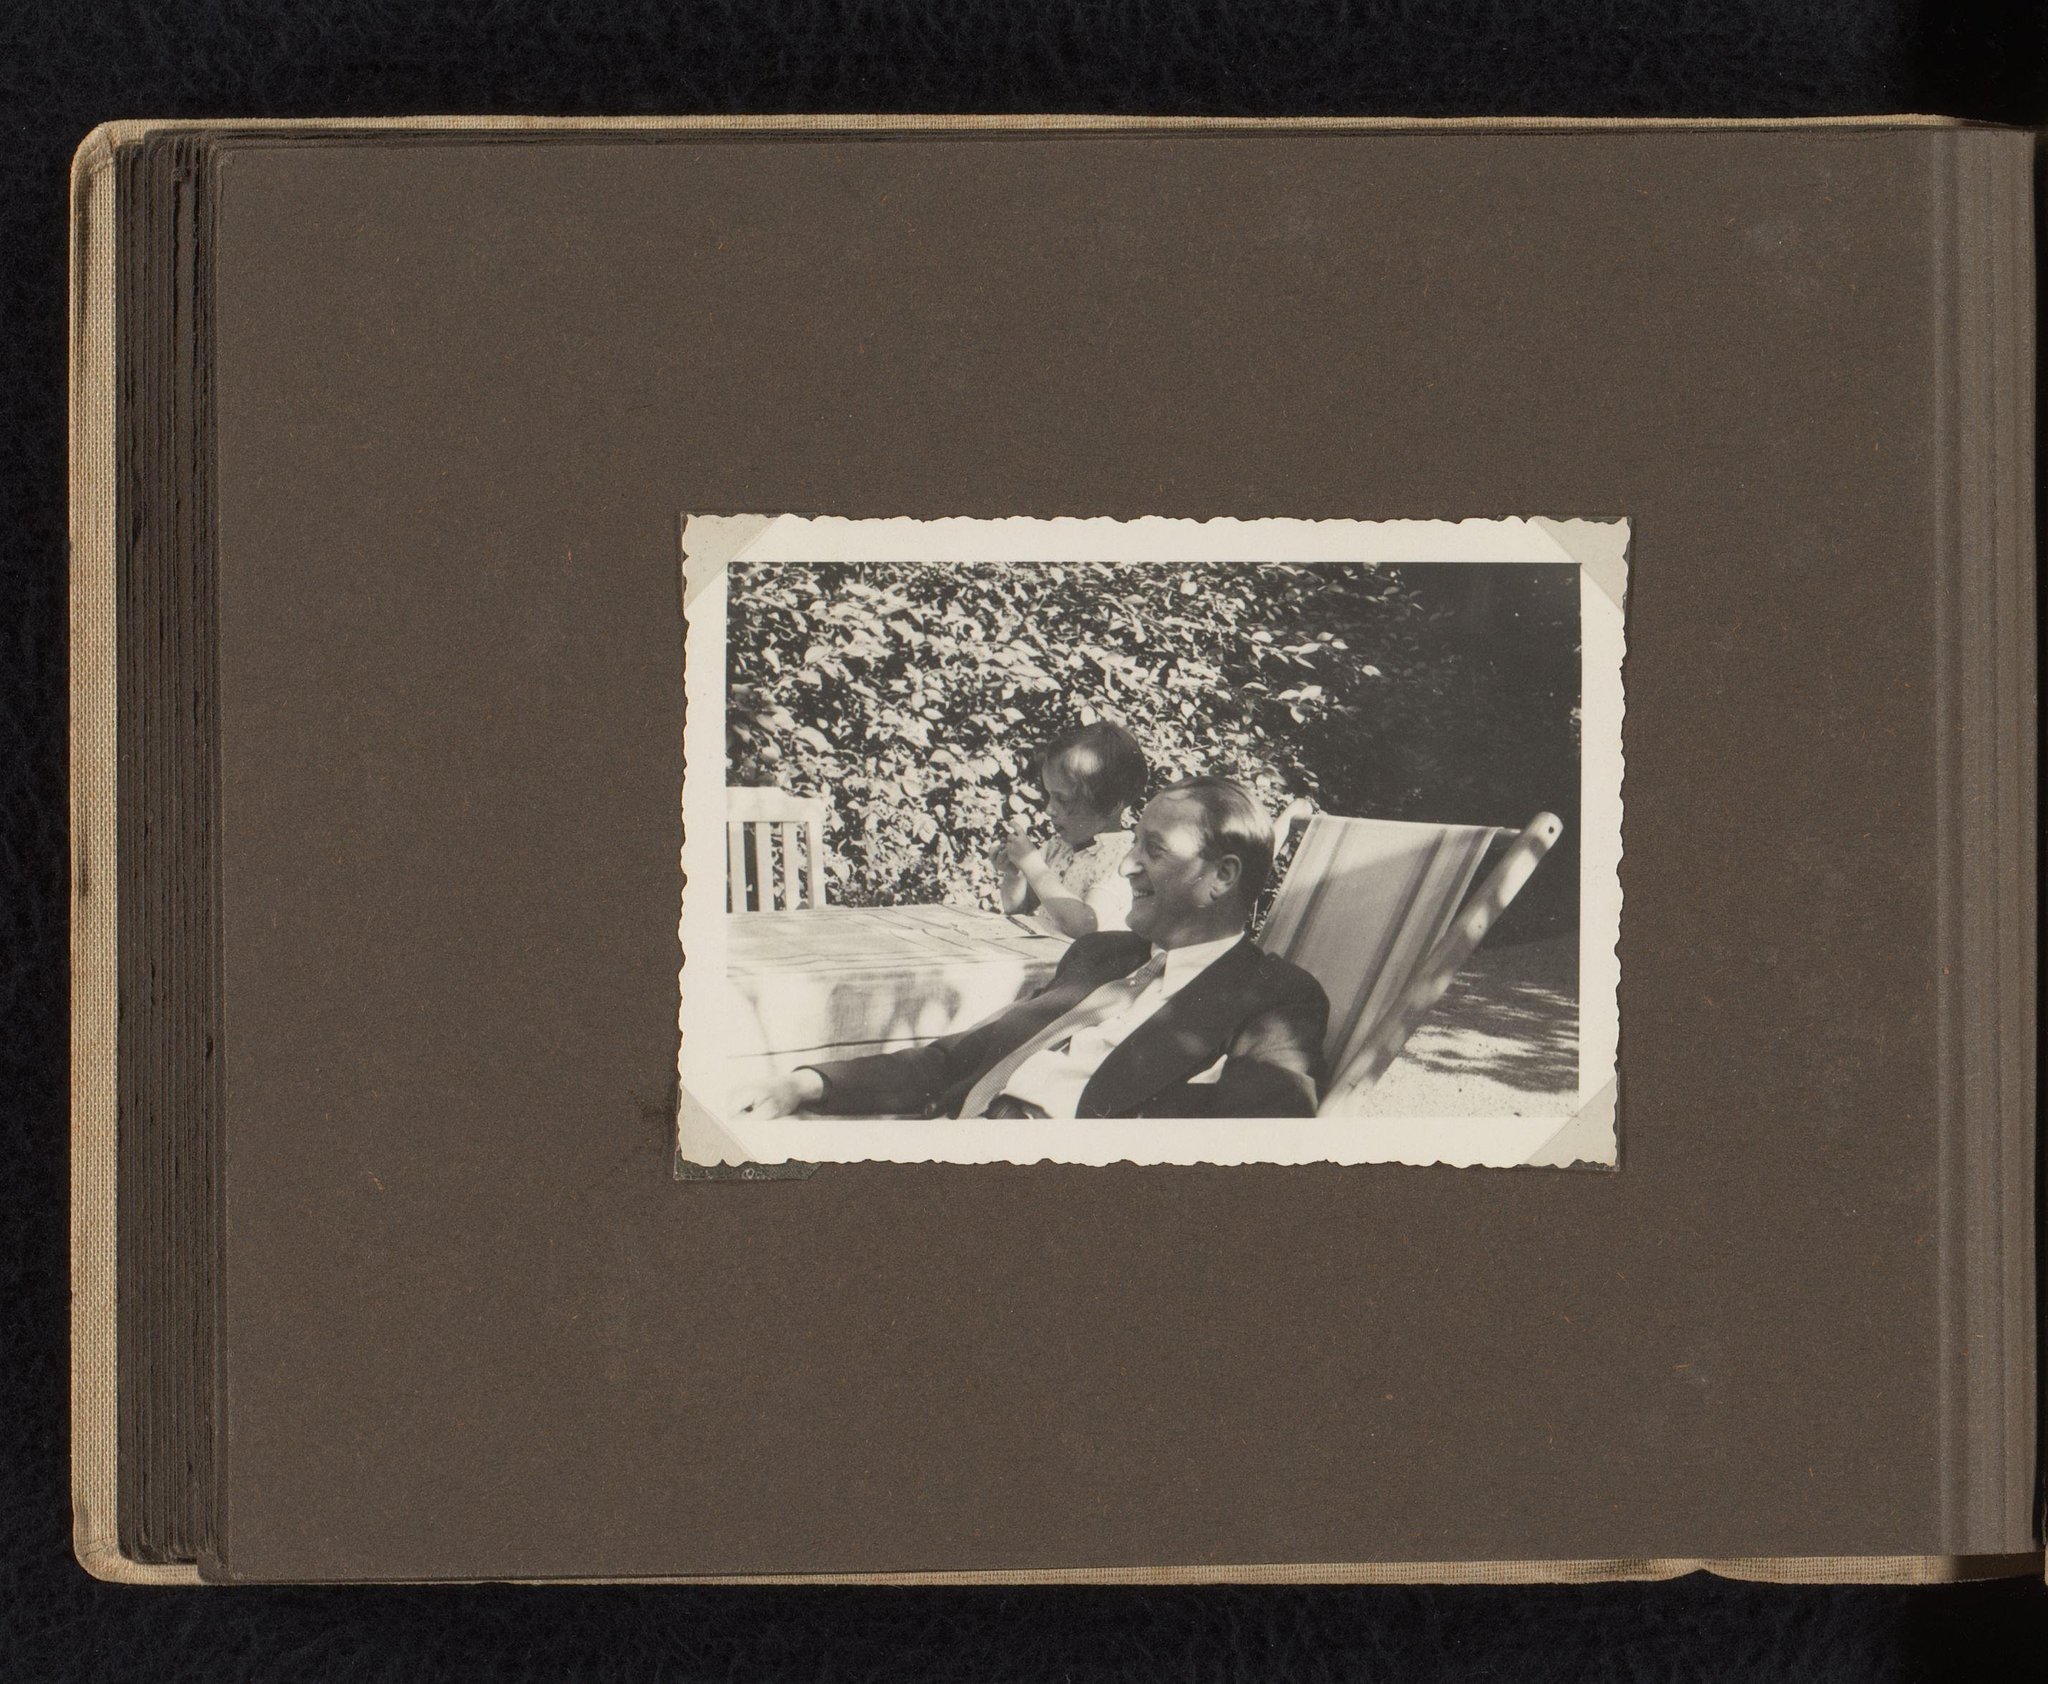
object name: album leaf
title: Isabel Wachenheimer met haar oom Willy Moos op een terras, 1932-1933, Duitsland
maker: else wachenheimer-moos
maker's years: 1895-1944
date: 1932-1933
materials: cardboard, photographic support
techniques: gelatin silver print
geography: germany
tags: isabel wachenheimer-elon, willy moos, family life at home, germany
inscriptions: date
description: Blad bevat een foto. Alle foto's van Isabel Wachenheimer en Willy Moos. Uit het album, half formaat, crèmekleurig stofomslag met koordbinding met banenmotief.